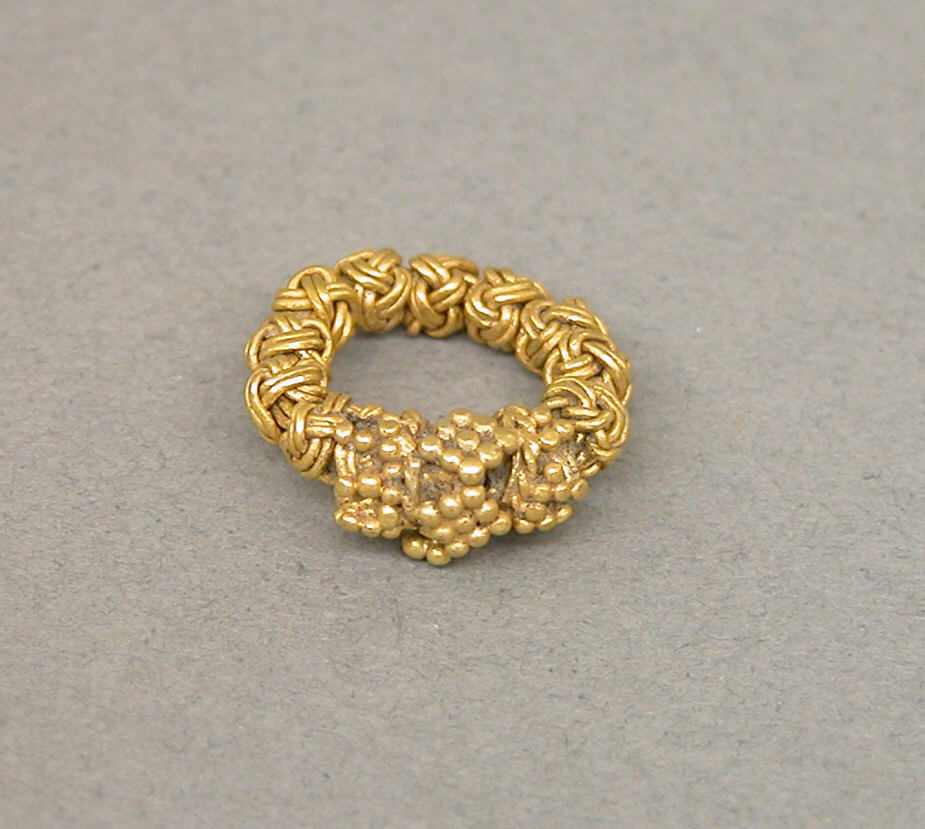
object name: ear clip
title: Ear Clip with Granulate and Knotted Wire Design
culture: indonesian, javanese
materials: gold